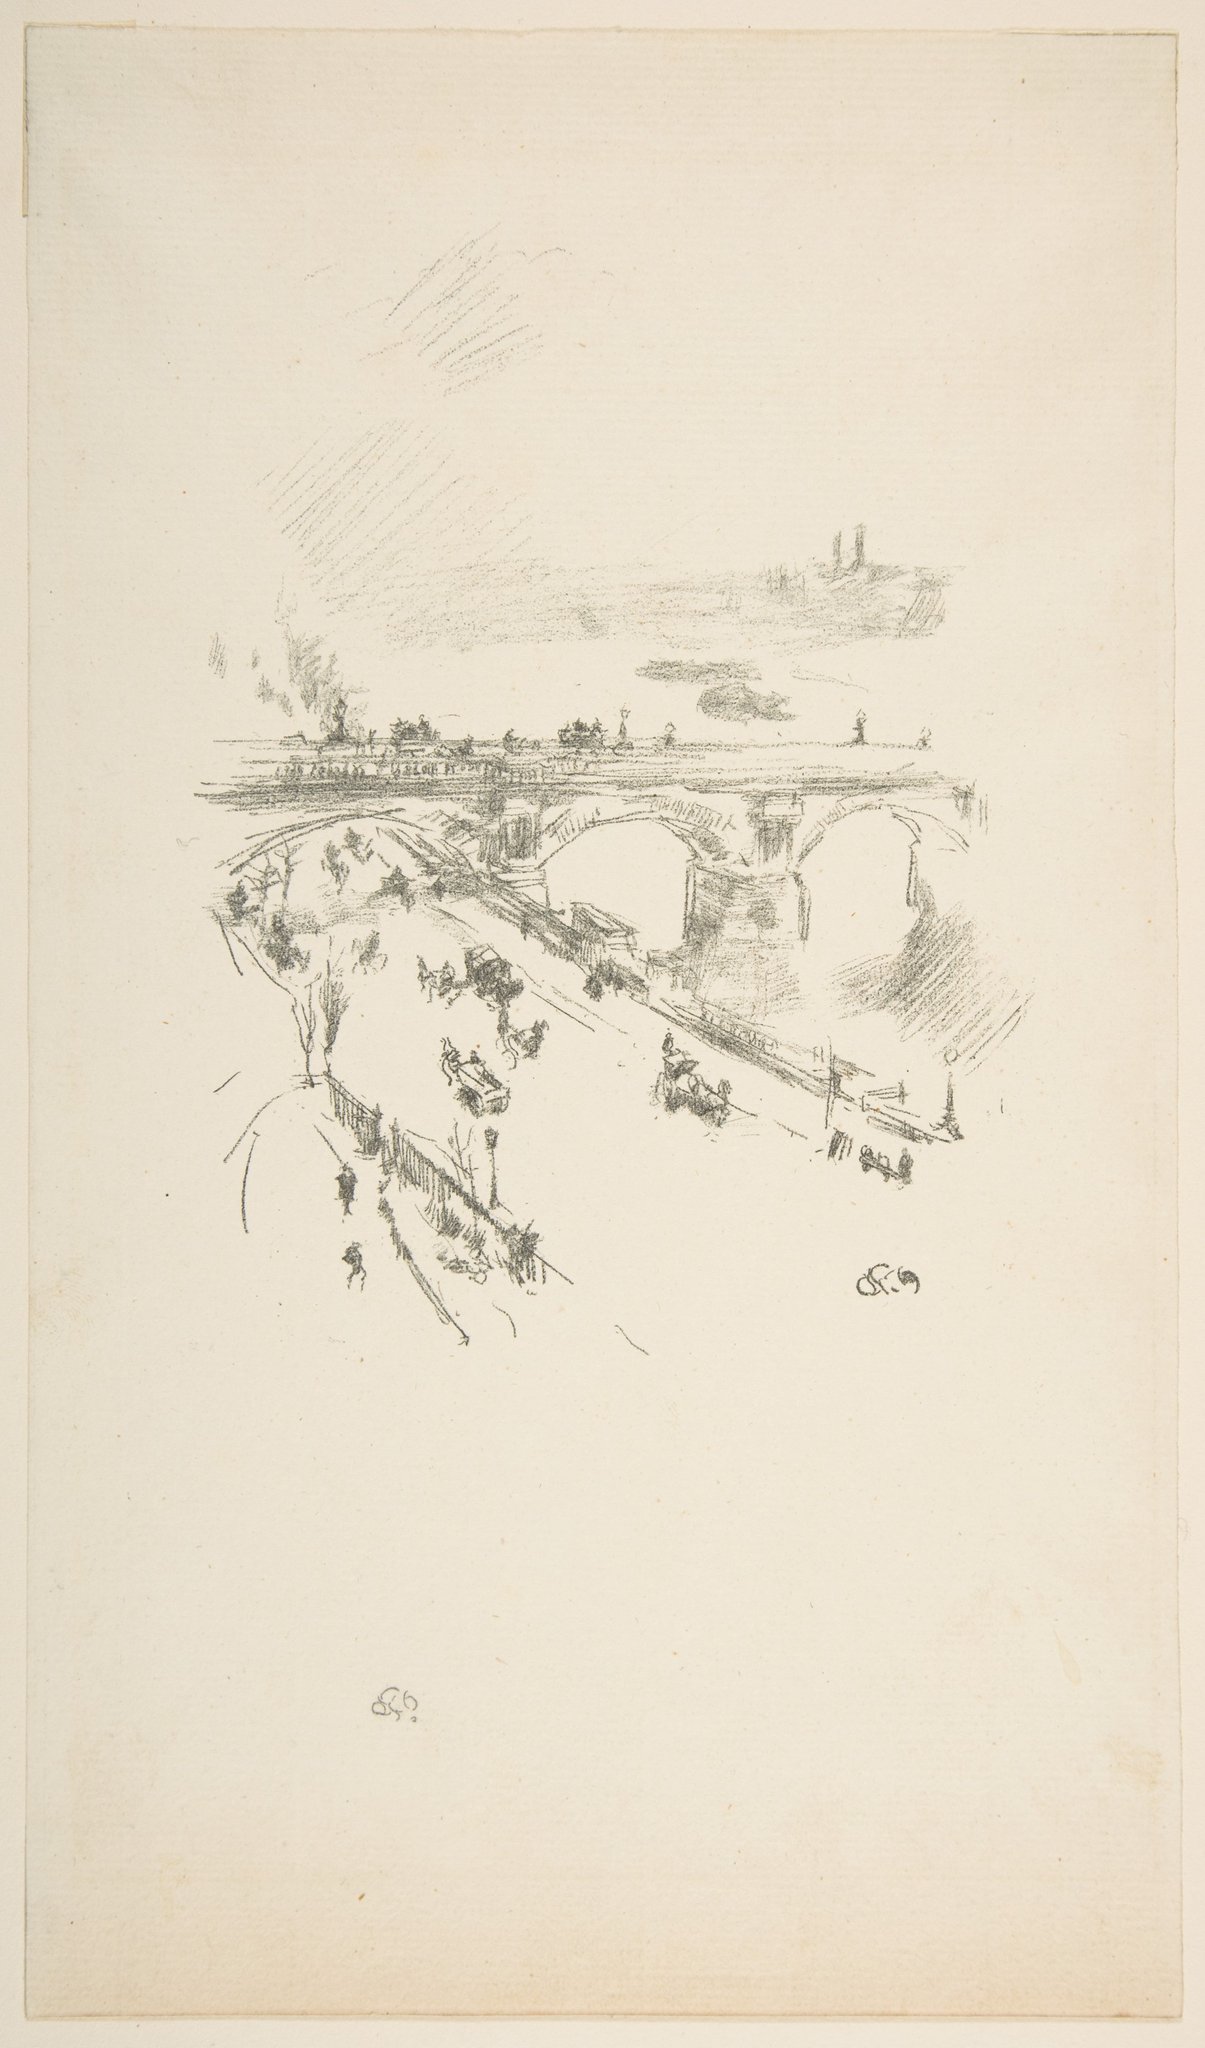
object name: print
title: Waterloo Bridge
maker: james mcneill whistler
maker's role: artist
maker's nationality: american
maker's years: 1834-1903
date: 1896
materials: ink, paper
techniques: printing, lithography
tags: bridges